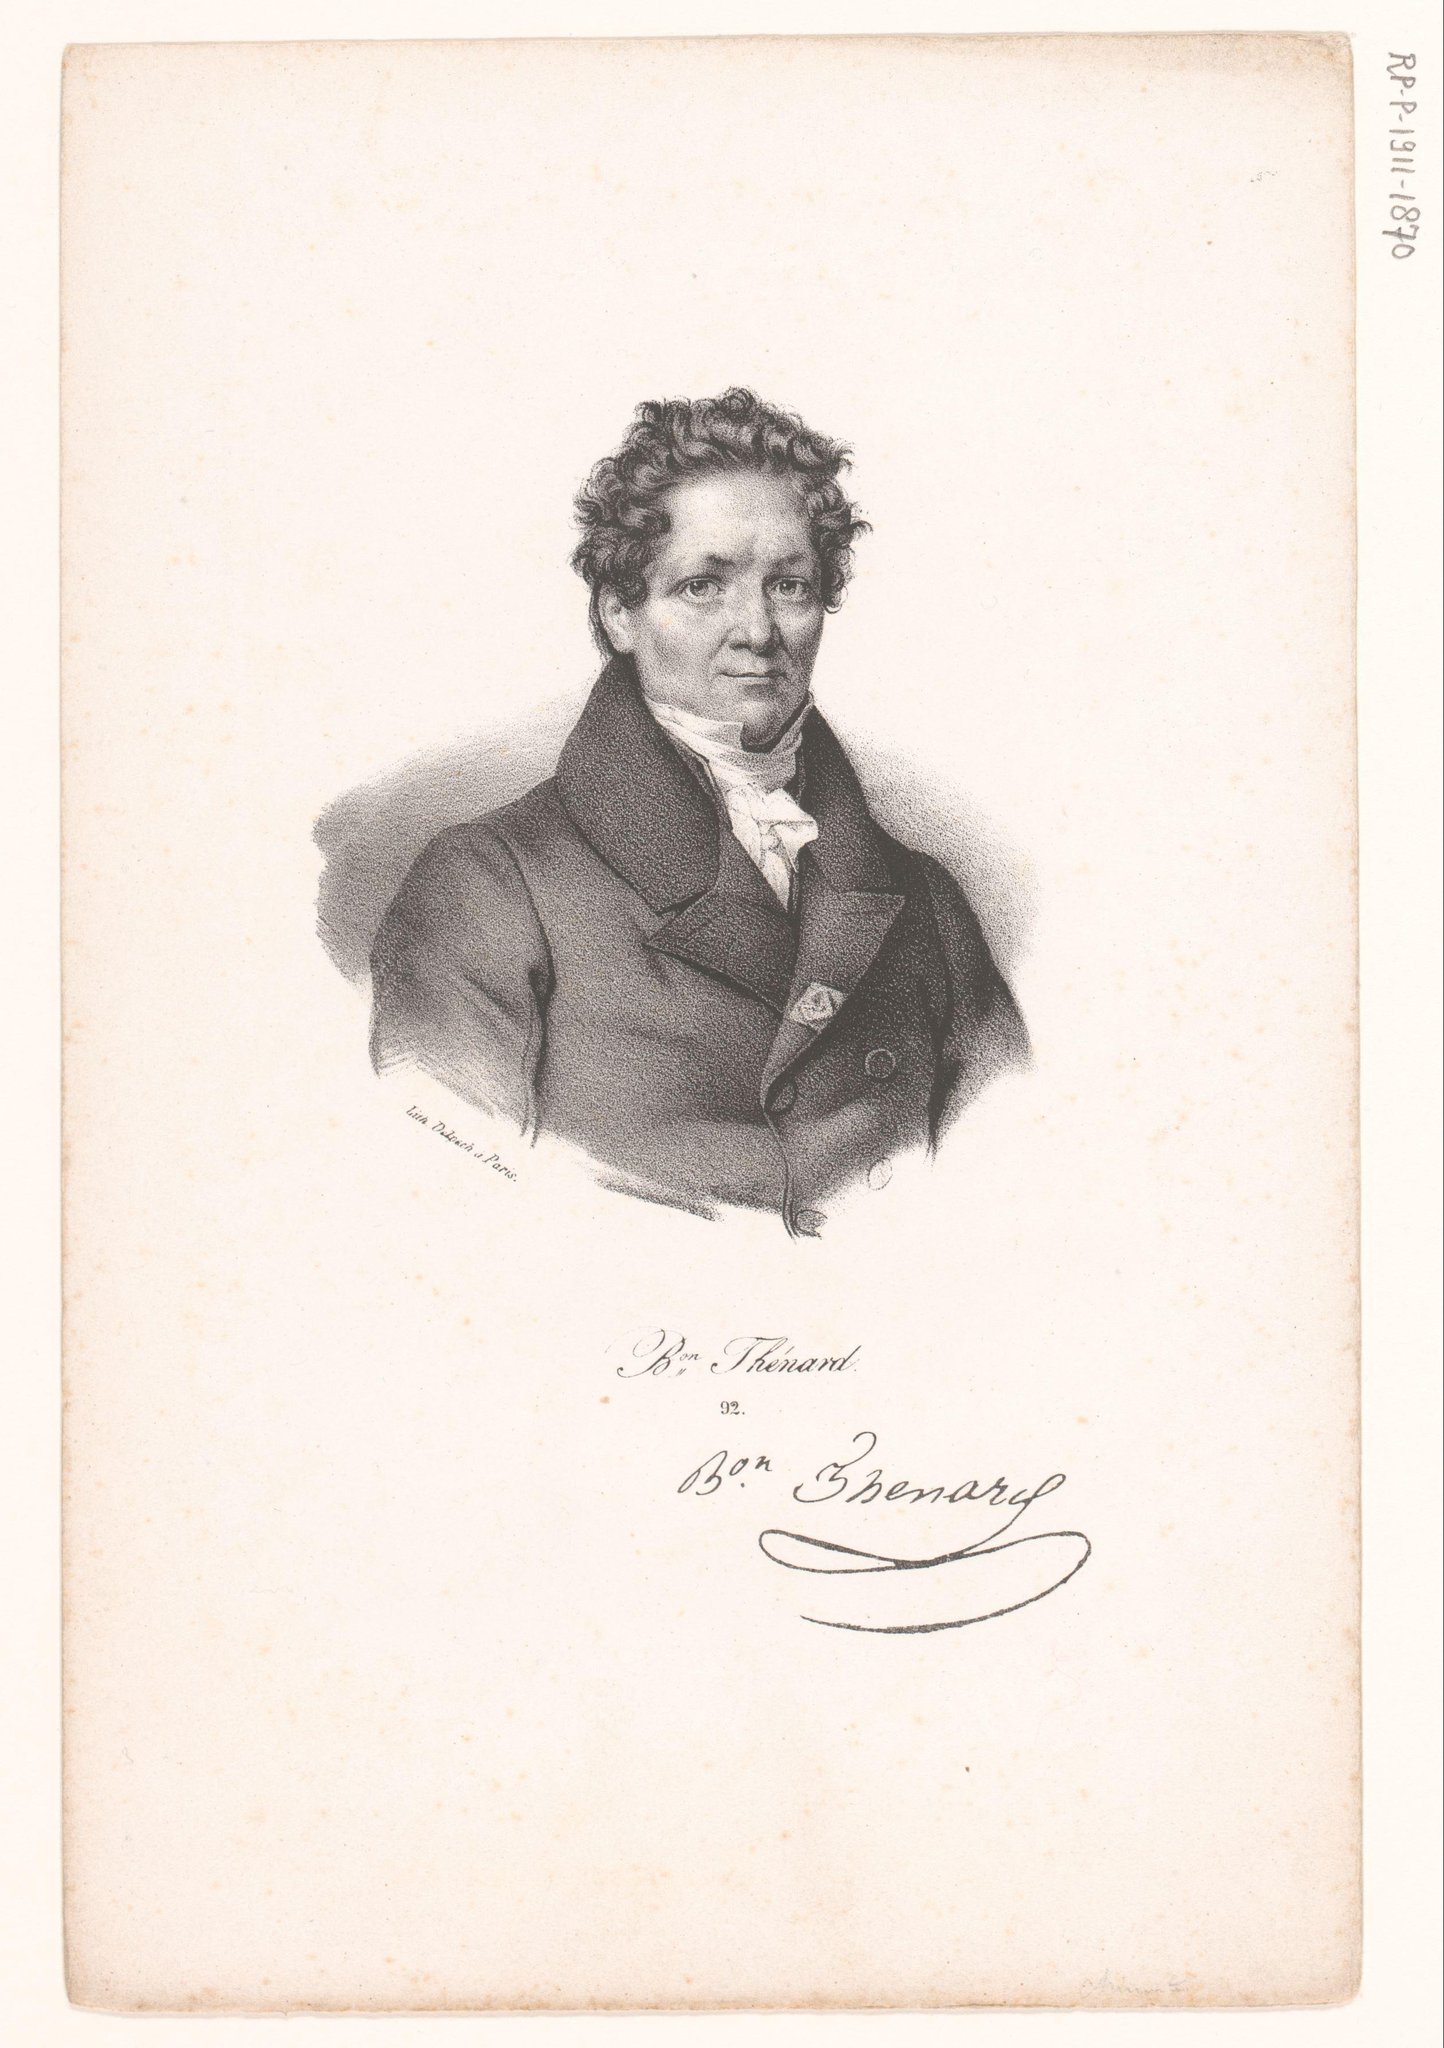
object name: print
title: Portret van baron Louis Jacques Thénard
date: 1830-1842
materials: paper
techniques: lithograph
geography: paris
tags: historical persons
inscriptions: collector's mark: Lugt 2228a